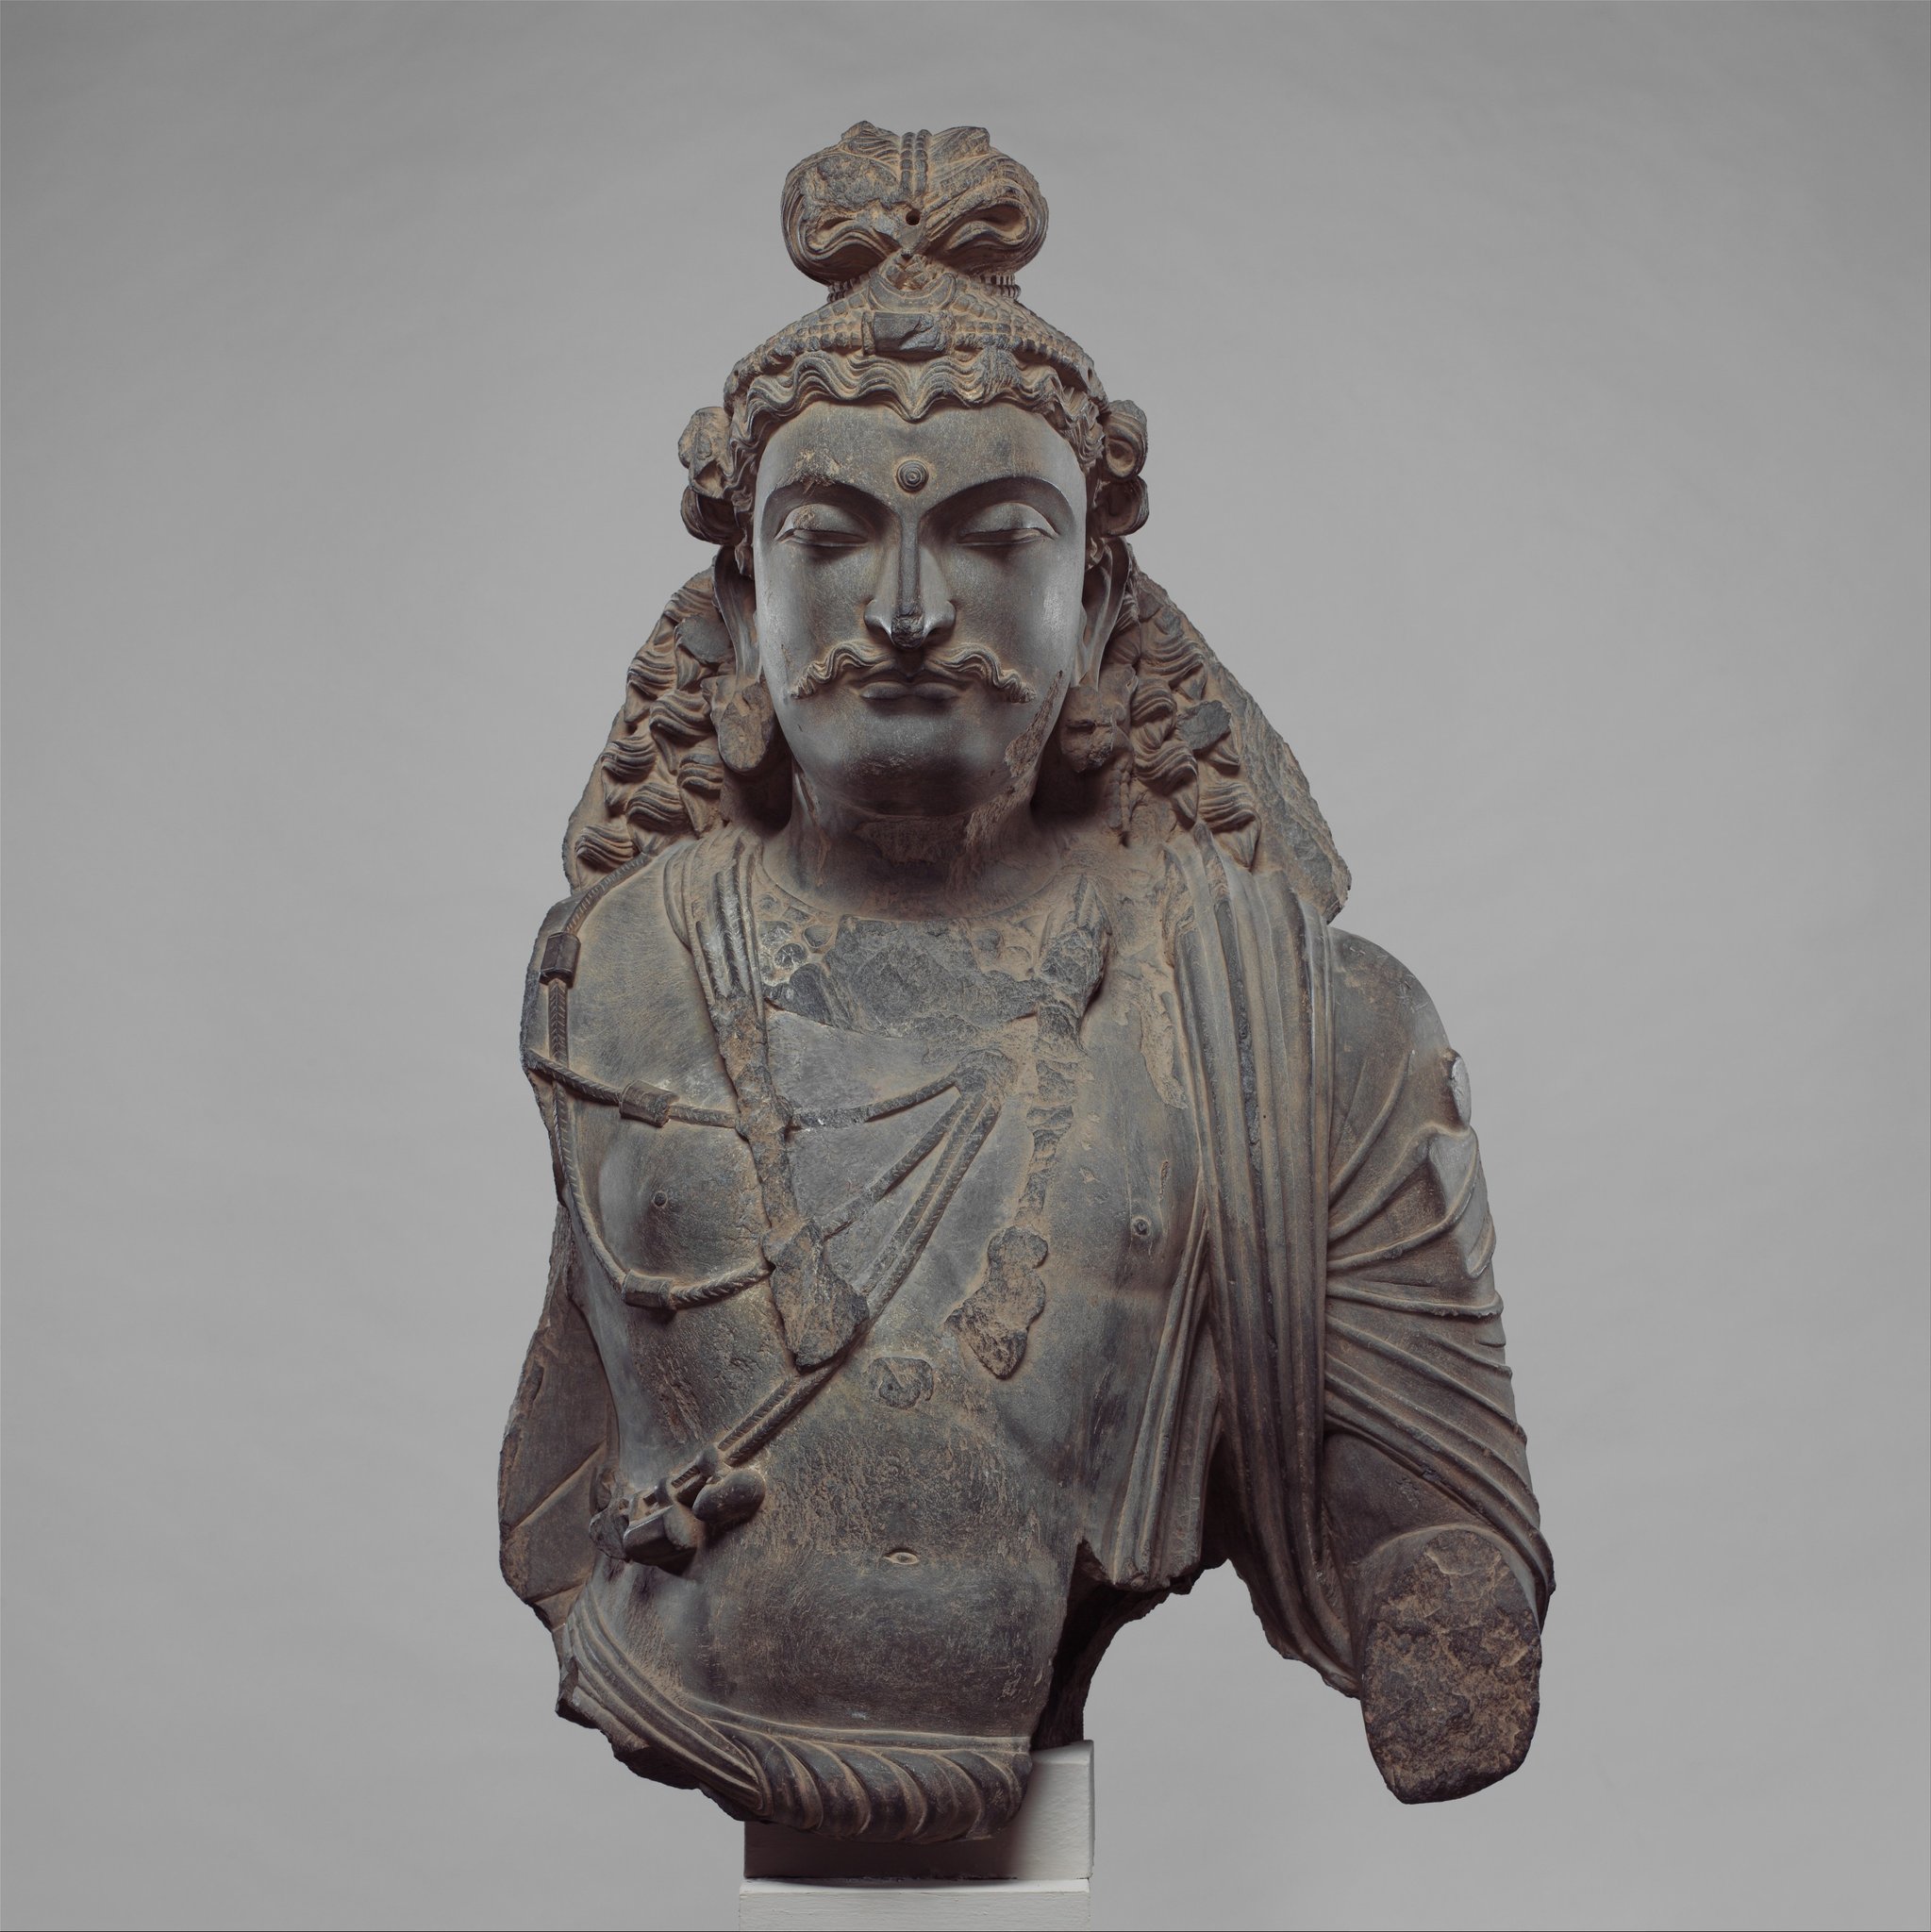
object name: bust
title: Bust of a Bodhisattva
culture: gandhara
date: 301-500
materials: stone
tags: gandhara,buddhism,bodhisattvas